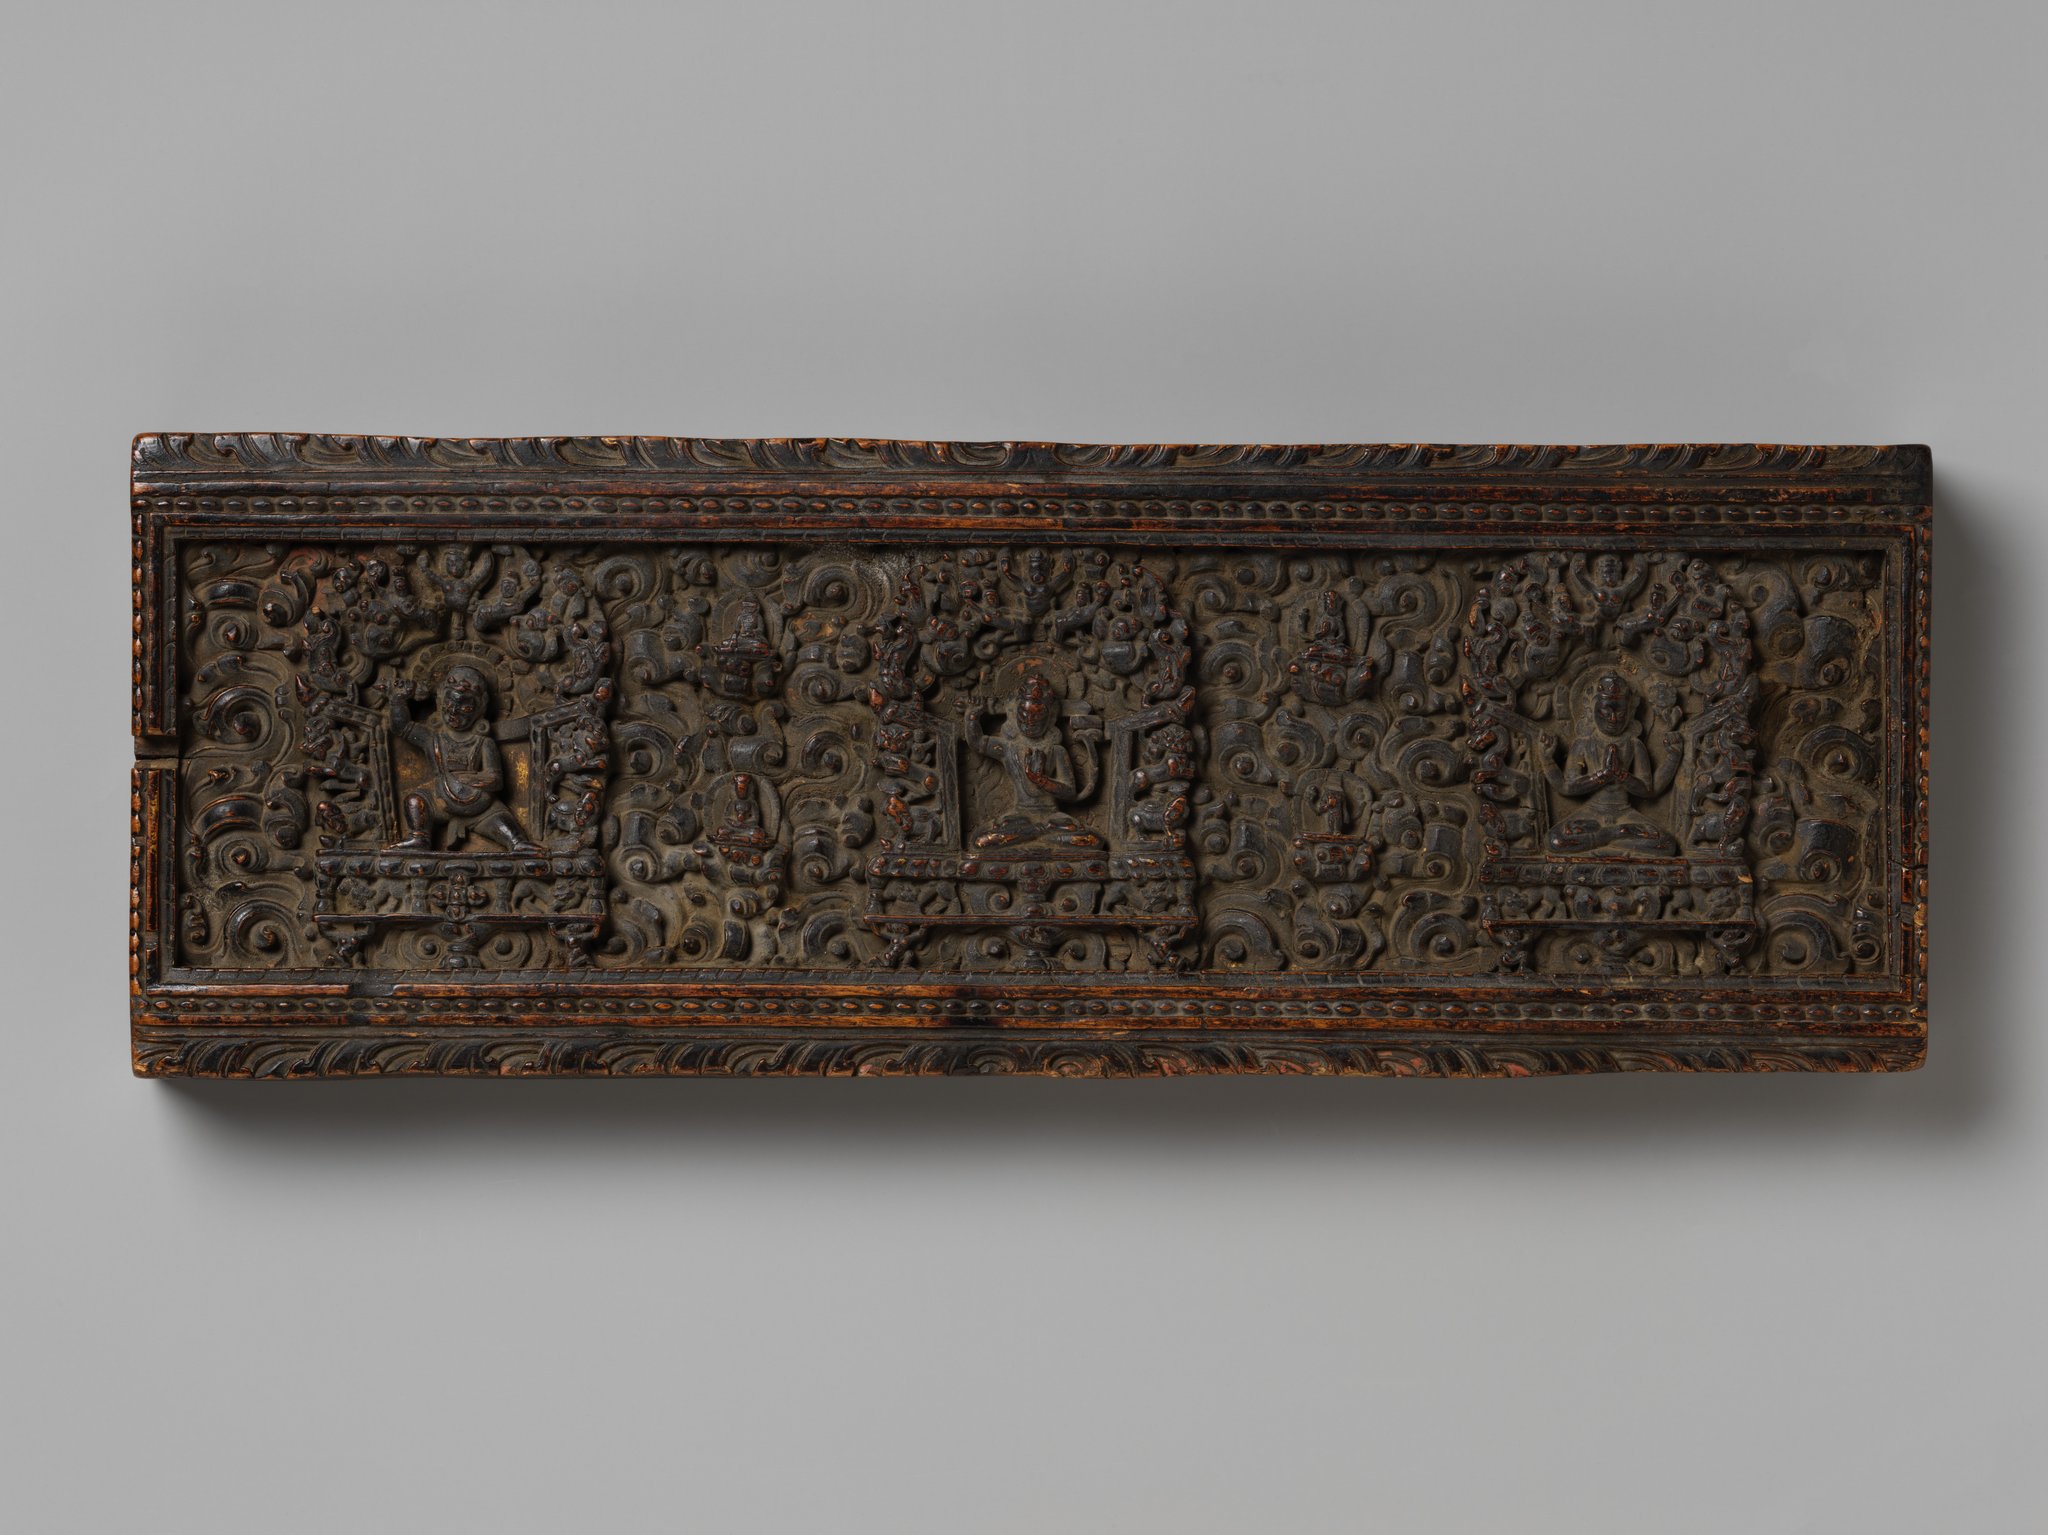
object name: manuscript cover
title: Manuscript Cover with the Bodhisattva Manjushri Flanked by Vajrapani and Avalokiteshvara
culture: tibetan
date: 1301-1400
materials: wood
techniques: gilding